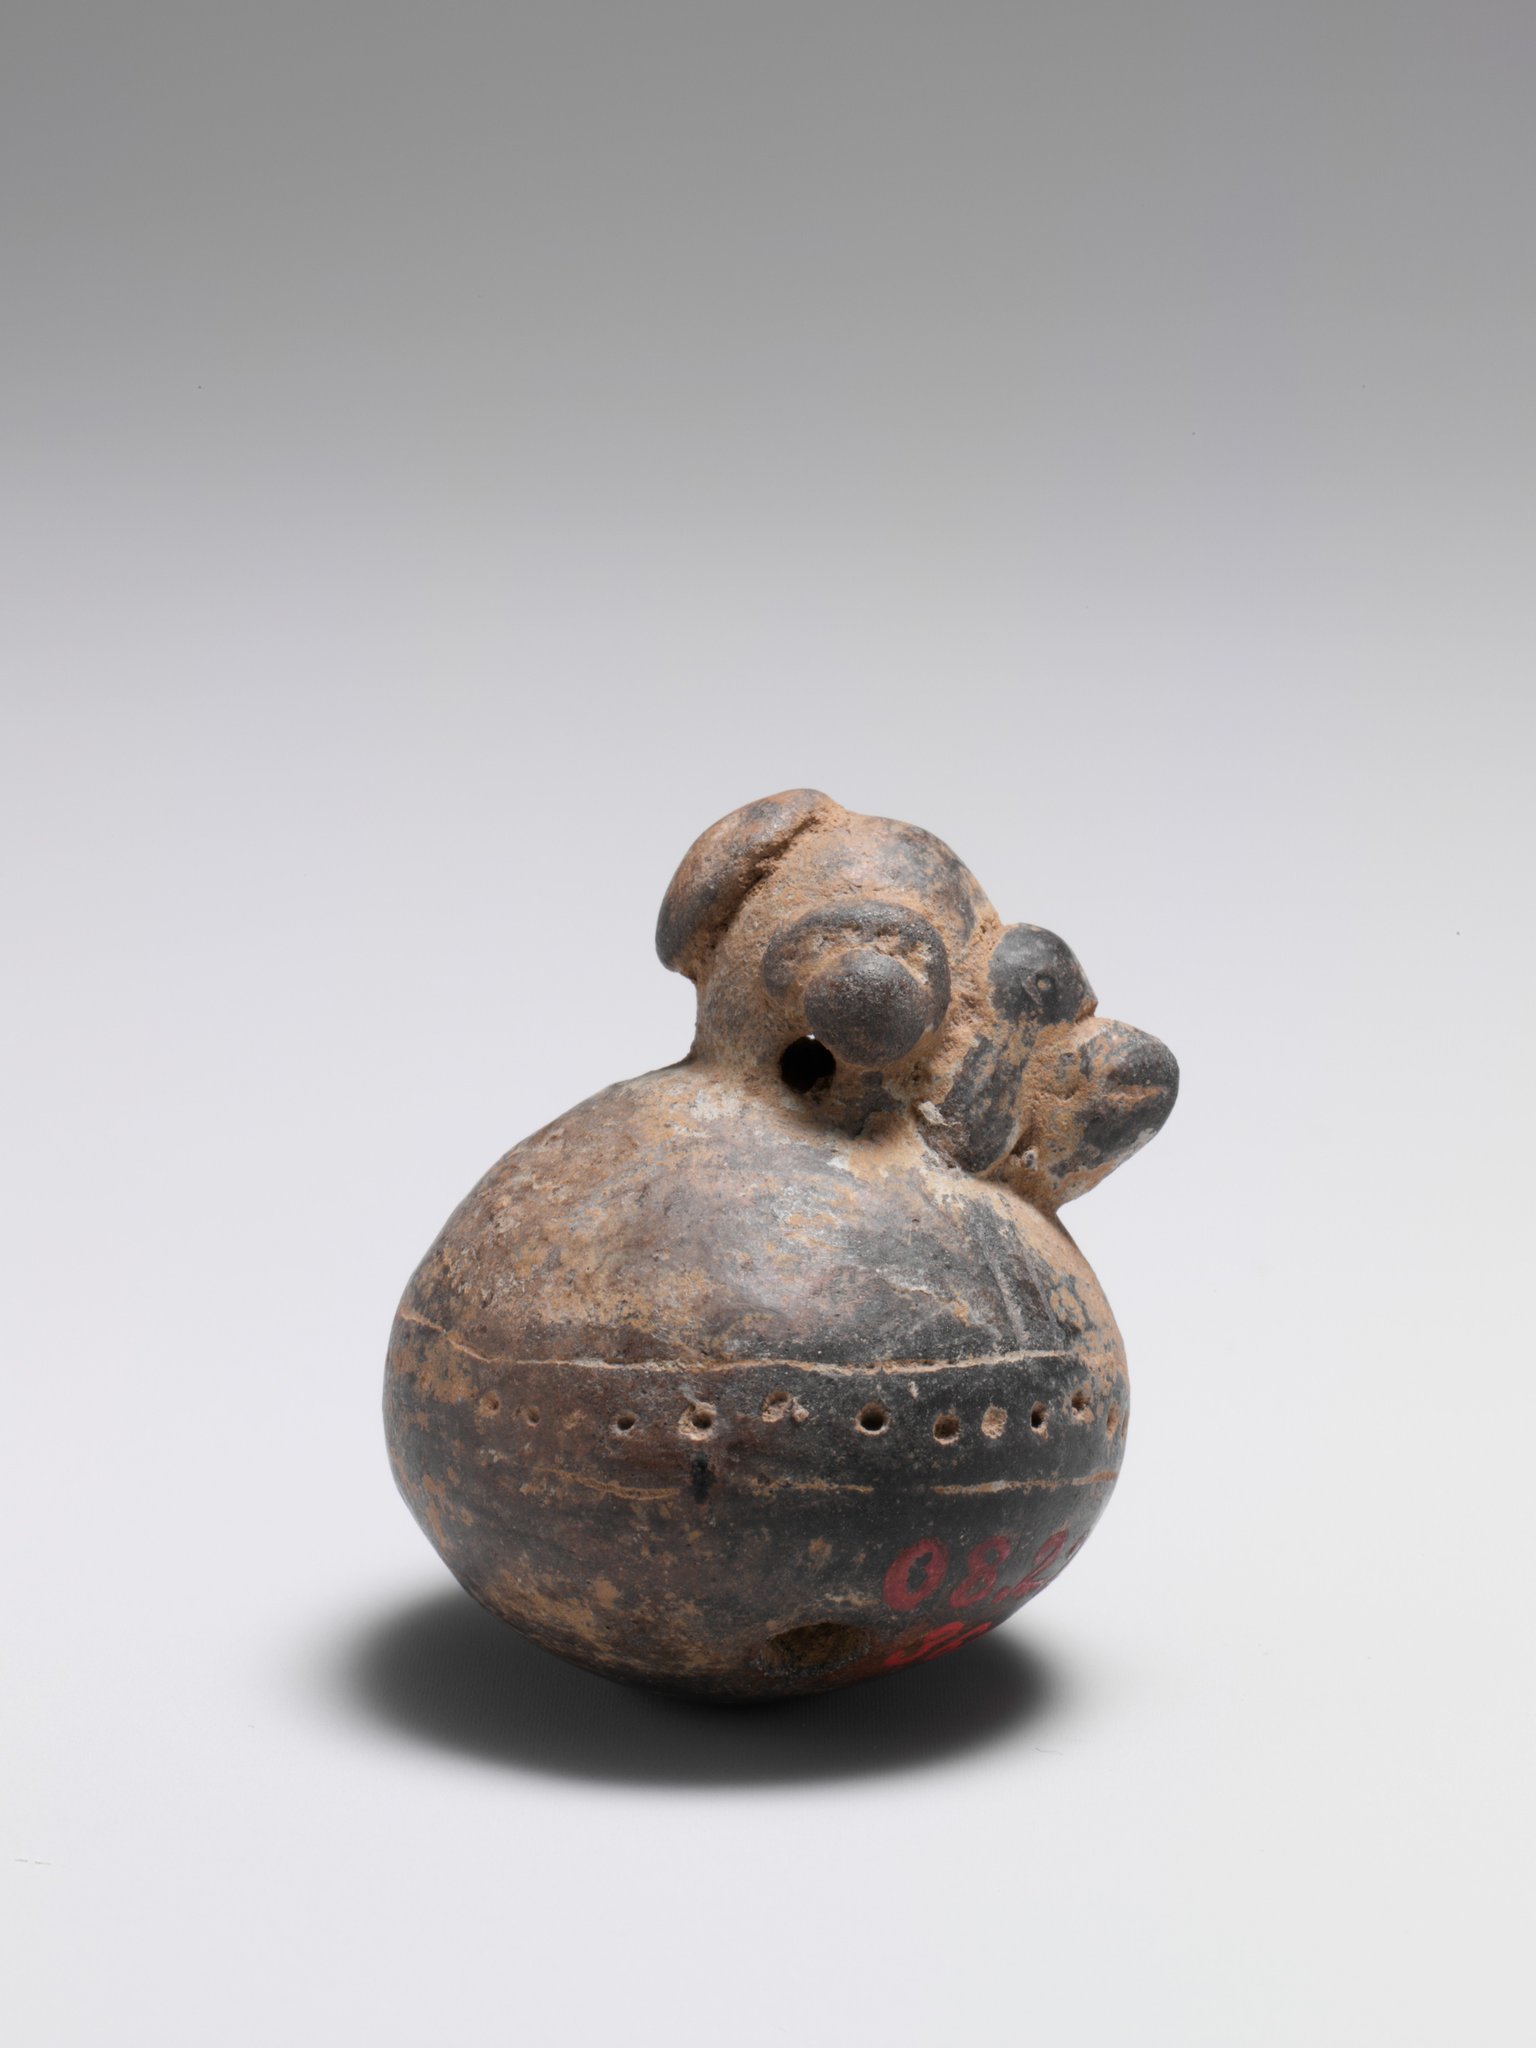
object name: pottery whistle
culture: costa rican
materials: clay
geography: costa rica